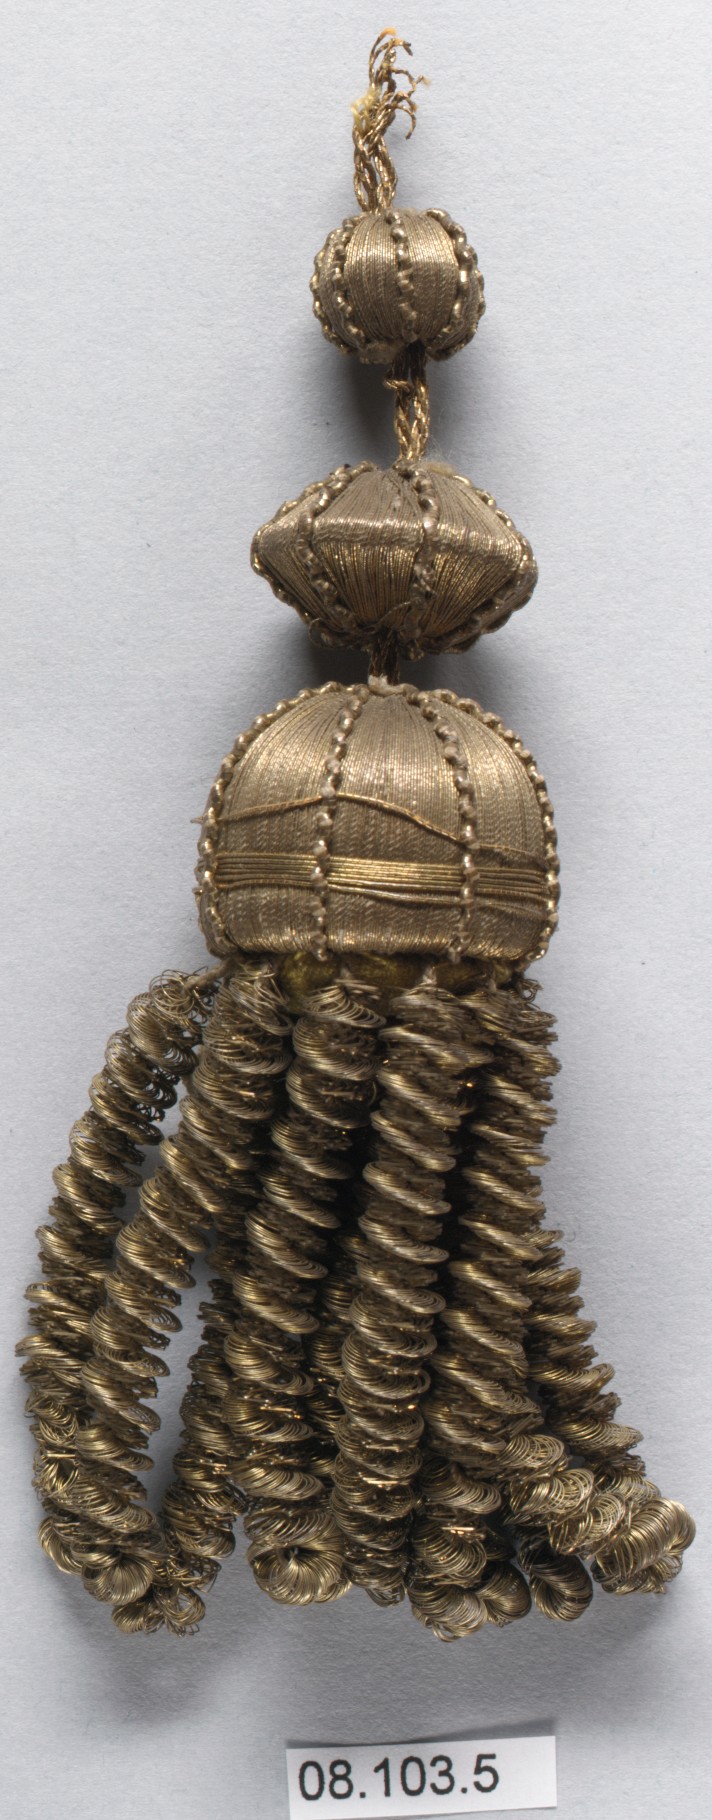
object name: tassel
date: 1701-1800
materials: metal thread